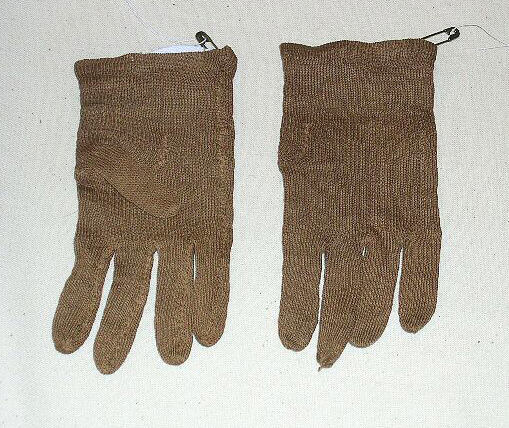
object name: glove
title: Gloves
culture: british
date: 1801-1833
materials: cotton